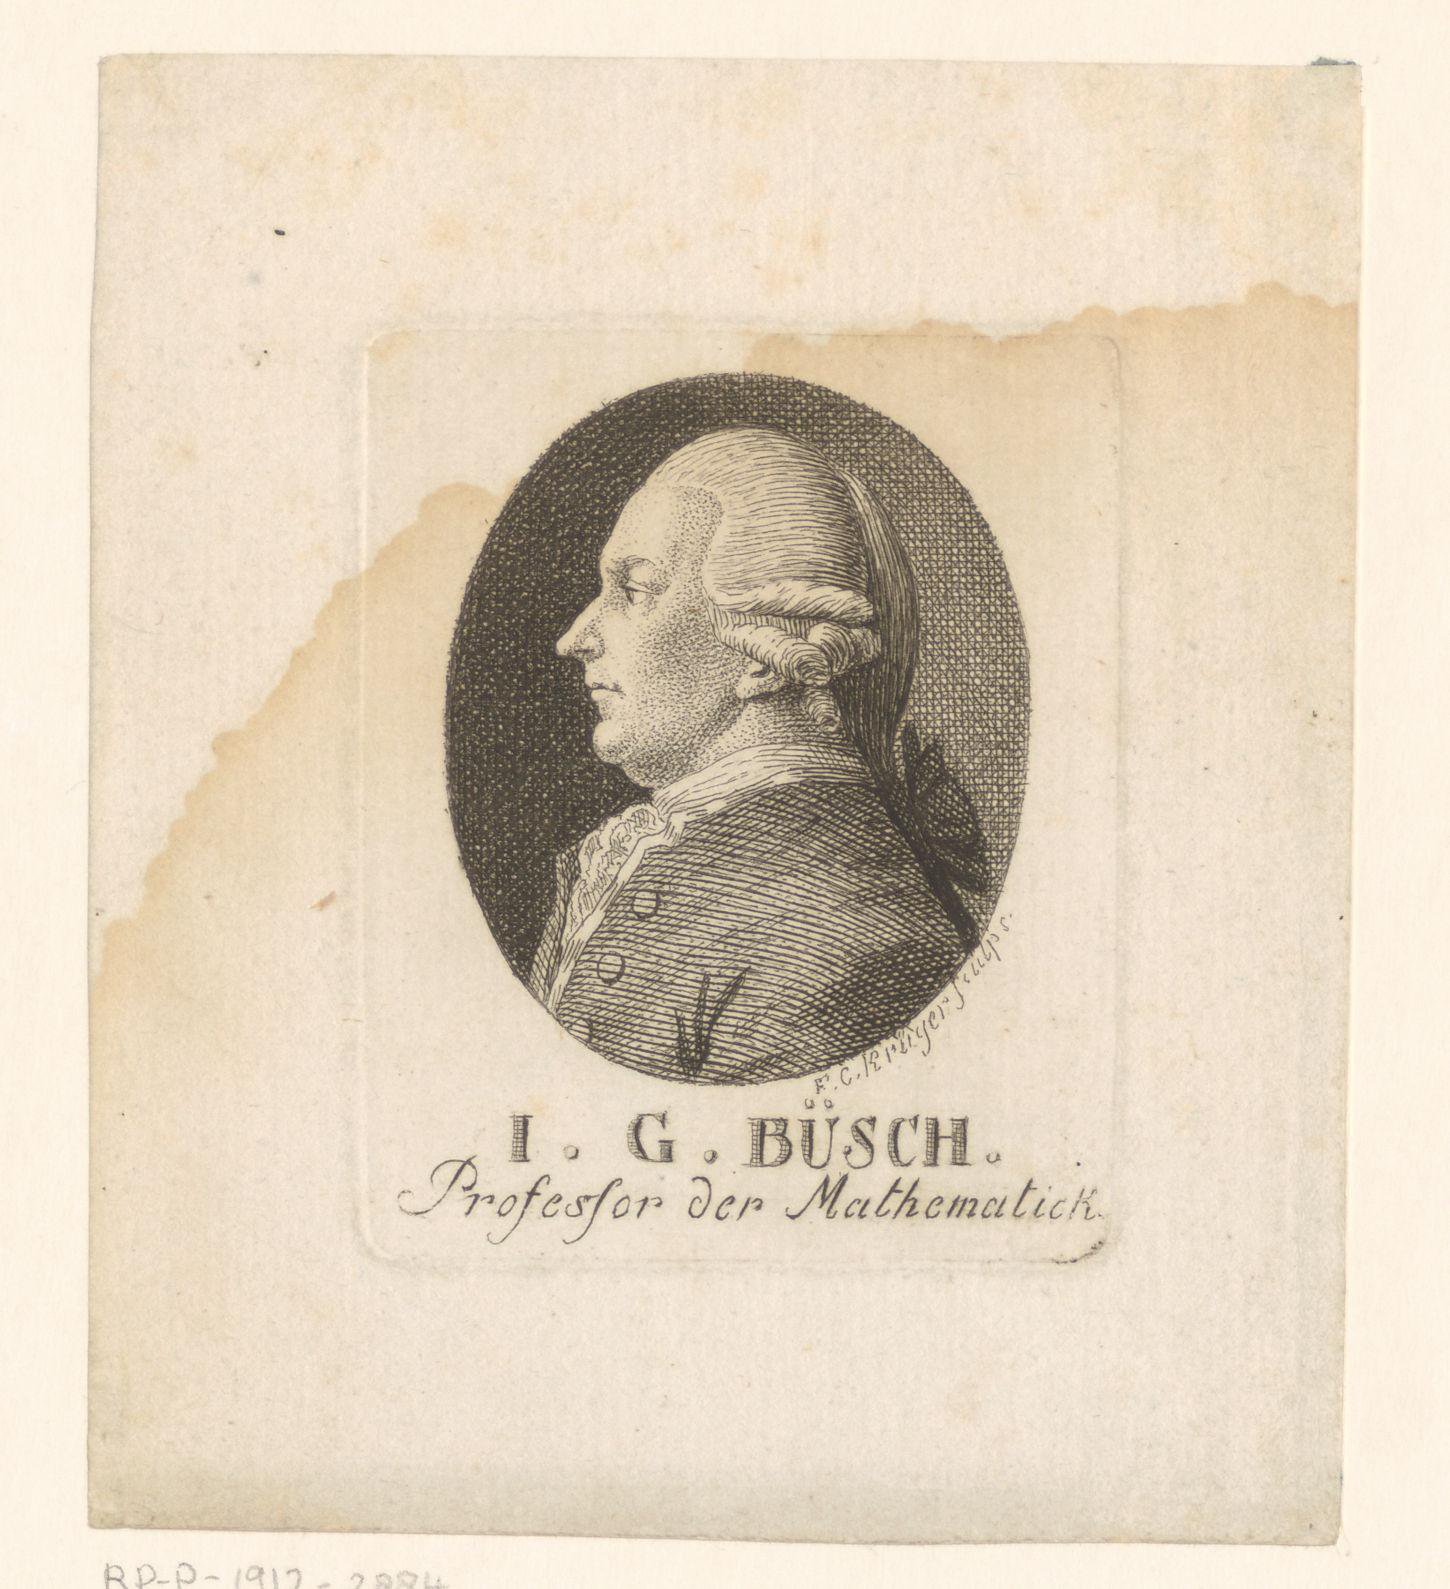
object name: print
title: Portret van Johann Georg Büsch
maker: friedrich christian krieger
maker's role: print maker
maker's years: 1774-1832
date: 1784-1832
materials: paper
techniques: etching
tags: germany, historical persons, mathematics (+ portrait of scholar, scientist)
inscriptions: collector's mark: Lugt 2228